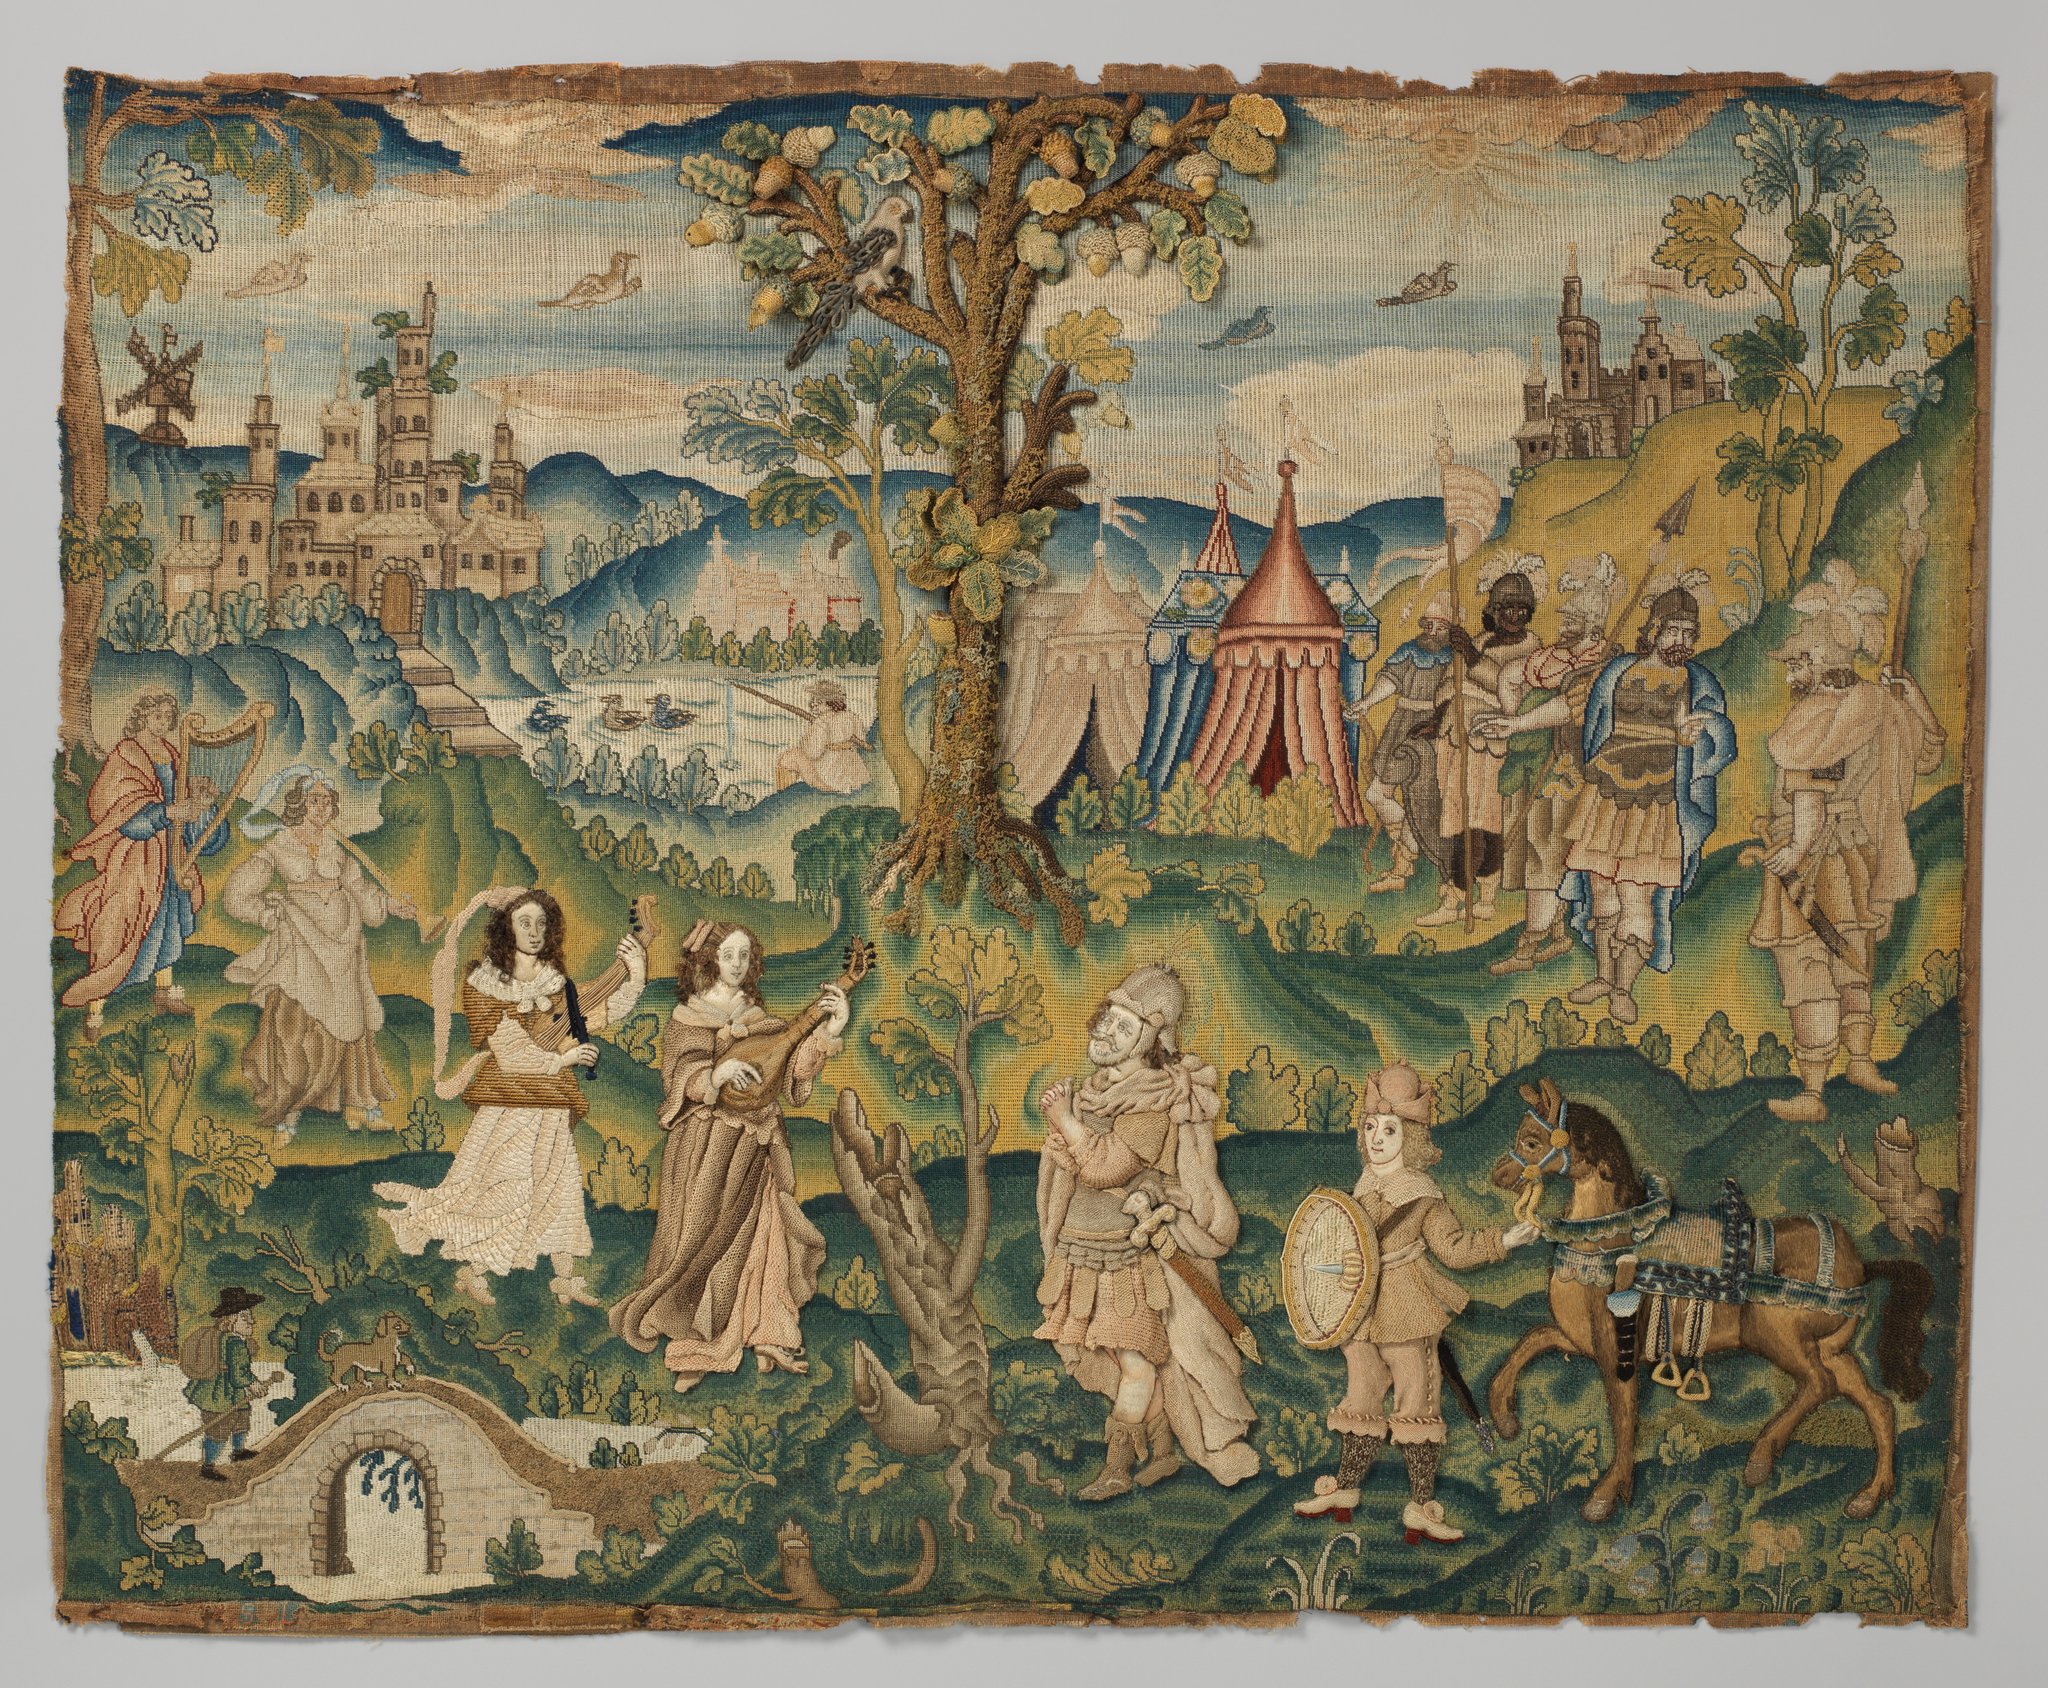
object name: embroidered picture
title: Return of Jephthah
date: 1651-1675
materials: canvas, metal thread, textile, silk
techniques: embroidery, stitching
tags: castles,tents,men,women,dogs,horses,musicians